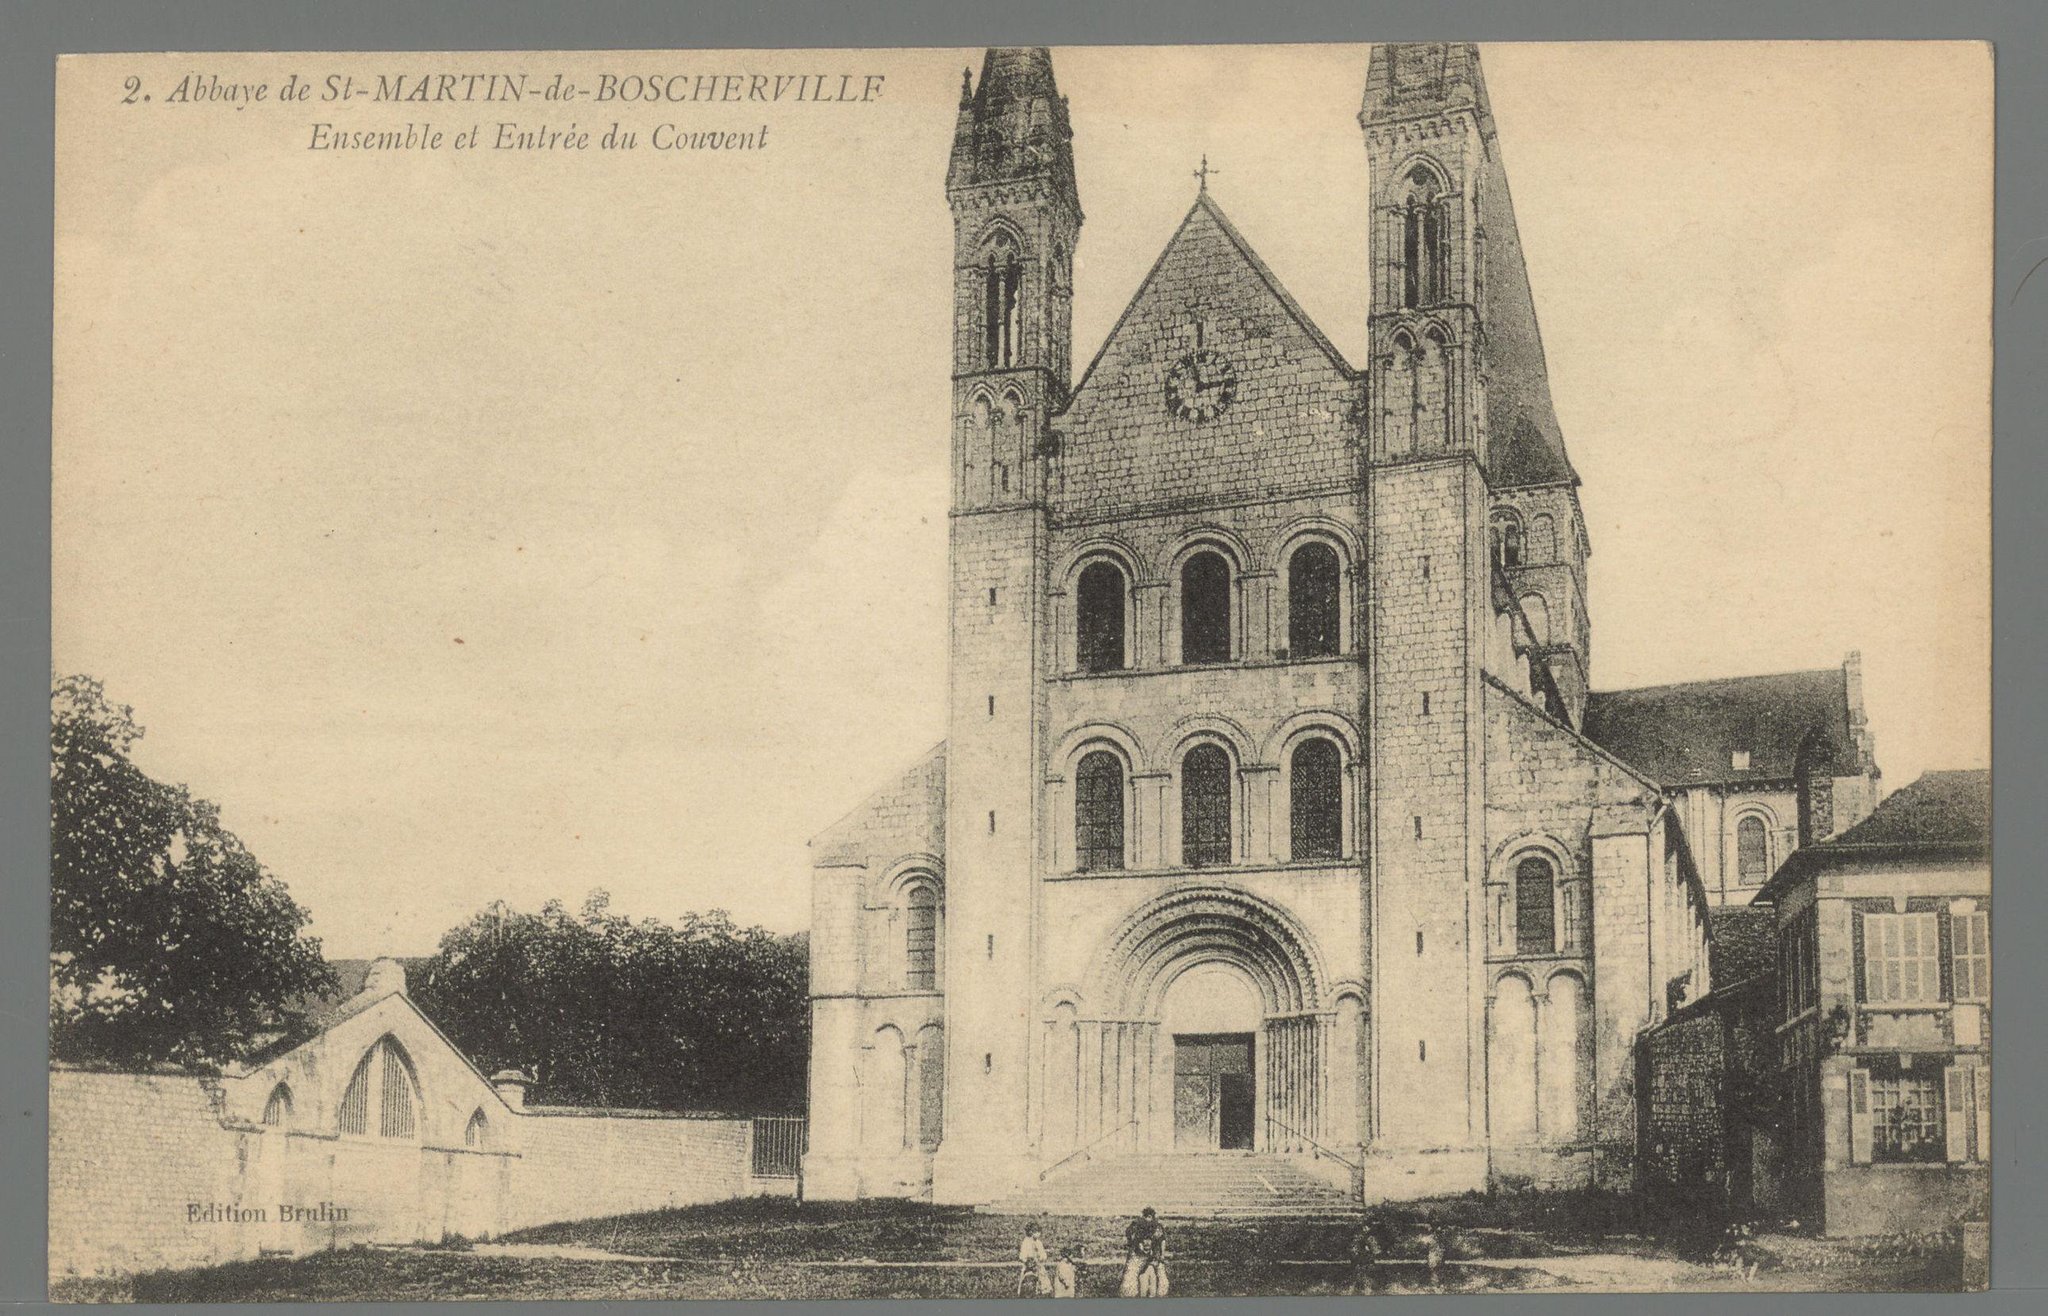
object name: ansichtkaart, prentbriefkaart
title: Abbaye de St.-Martin-de-Boscherville. Ensemble et Entrée du Couvent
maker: Anonymous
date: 1903-1920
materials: cardboard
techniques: photograph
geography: saint-martin-de-boscherville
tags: abbey, monastery, convent ~ roman catholic church, church (exterior)